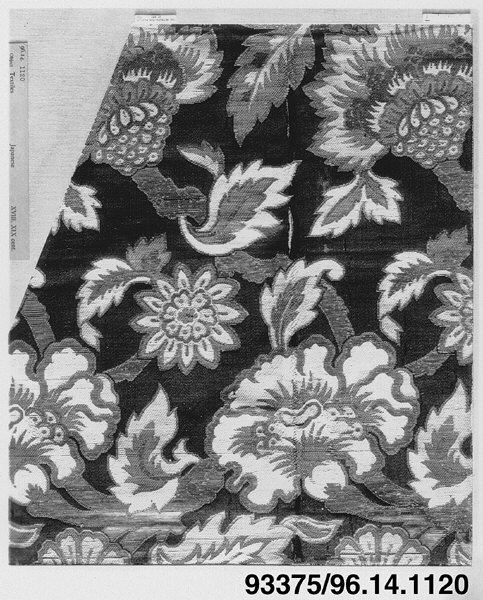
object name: piece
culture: japanese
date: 1701-1900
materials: silk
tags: leaves